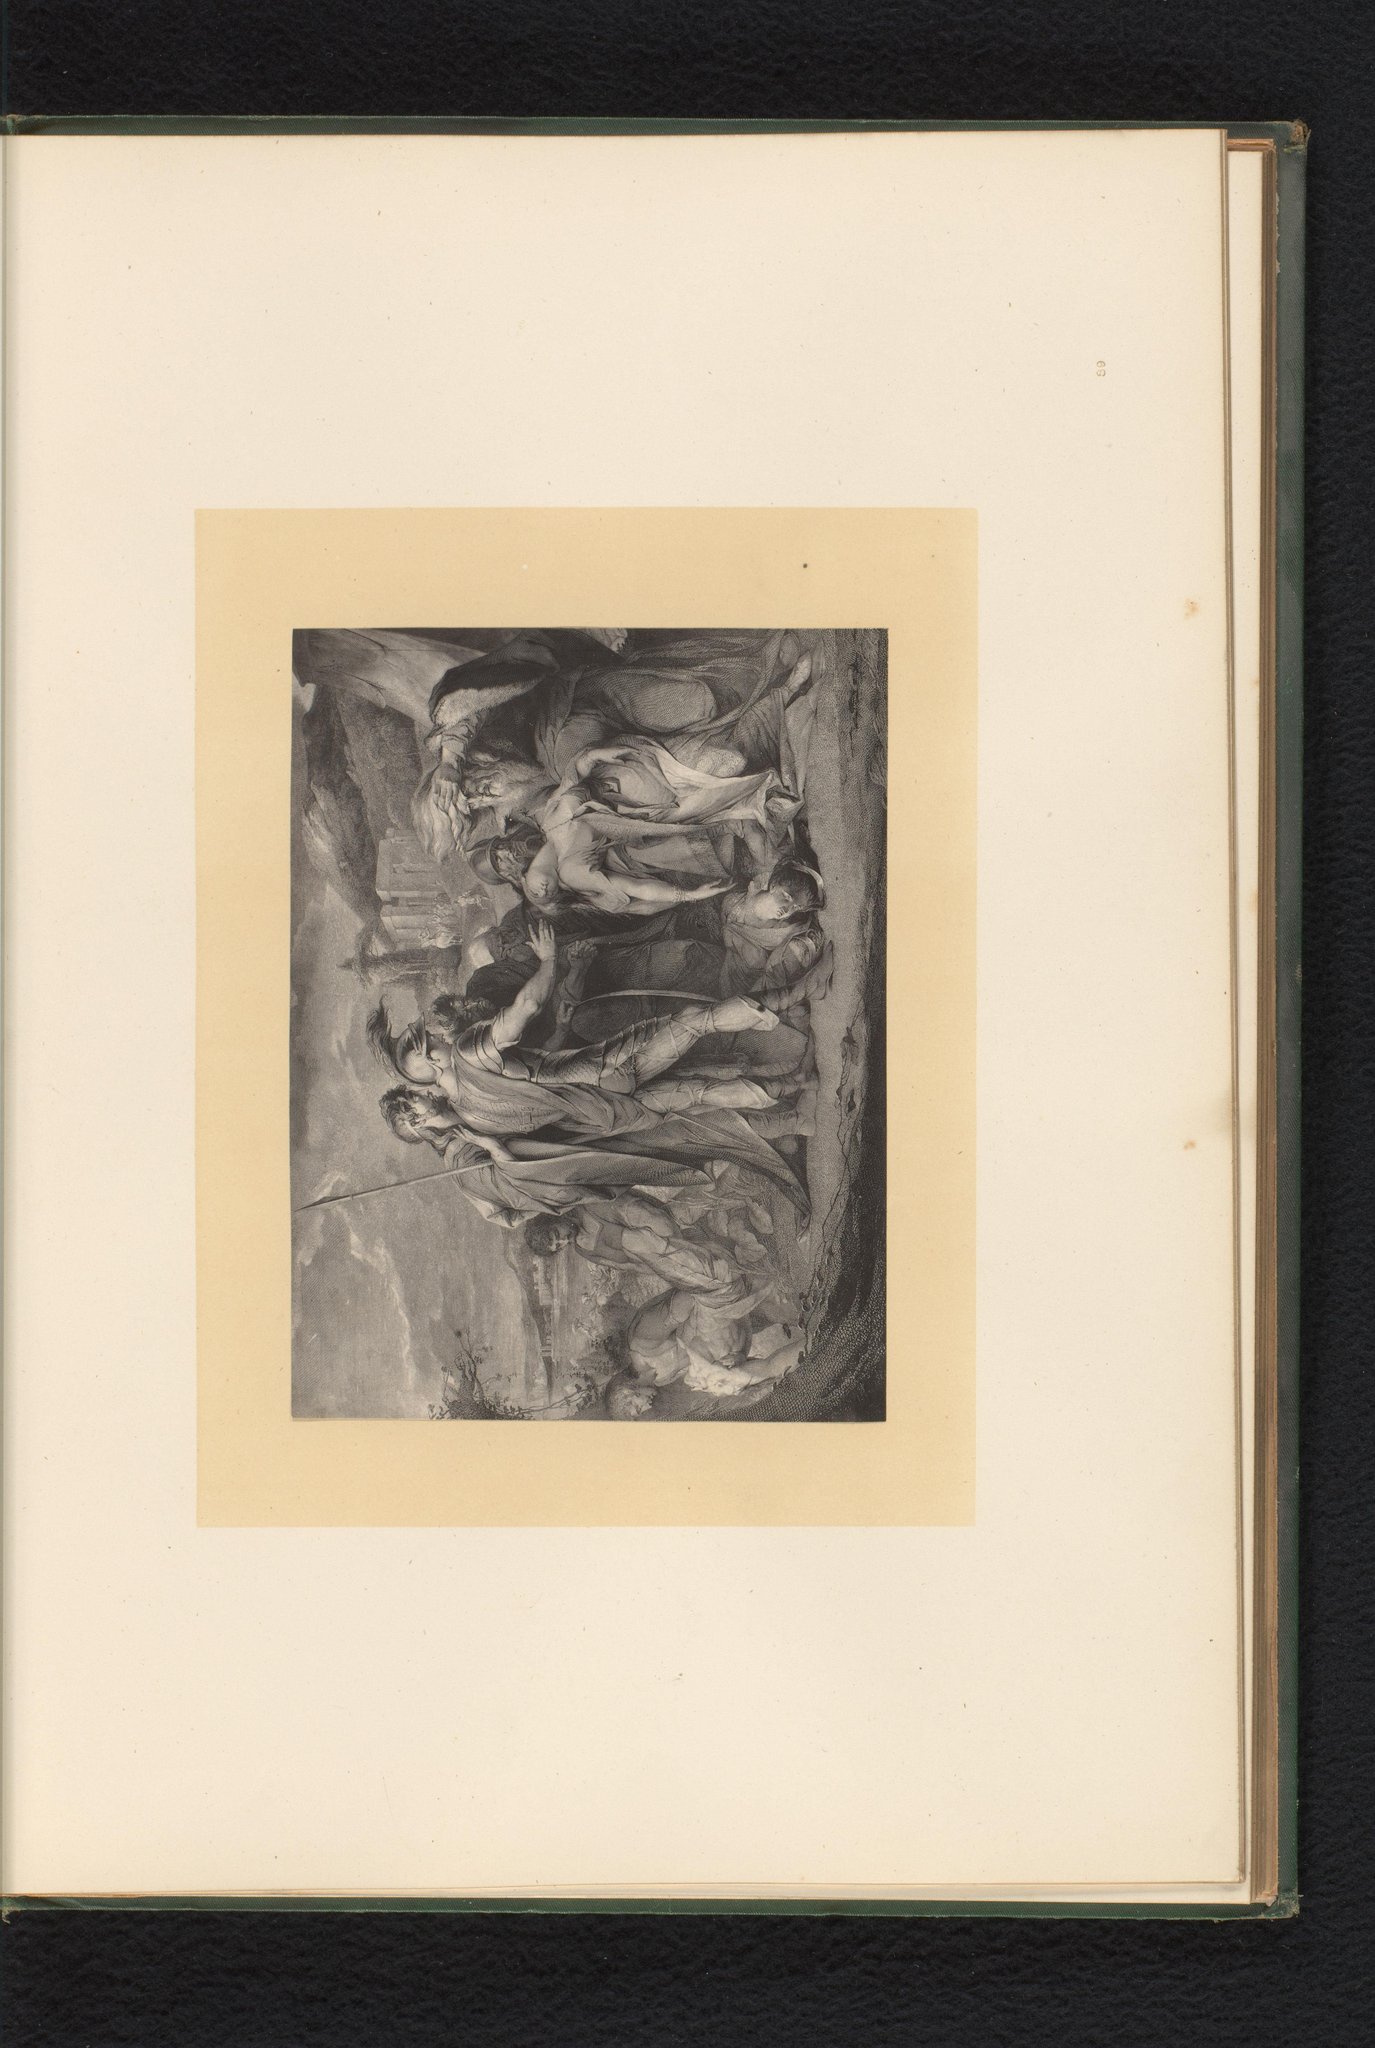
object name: reproduction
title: King Lear, Act V, Scene 3: A Camp near Dover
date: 1874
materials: paper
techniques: woodburytype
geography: london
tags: (shakespeare, king lear) specific works of literature (with author, title), king lear